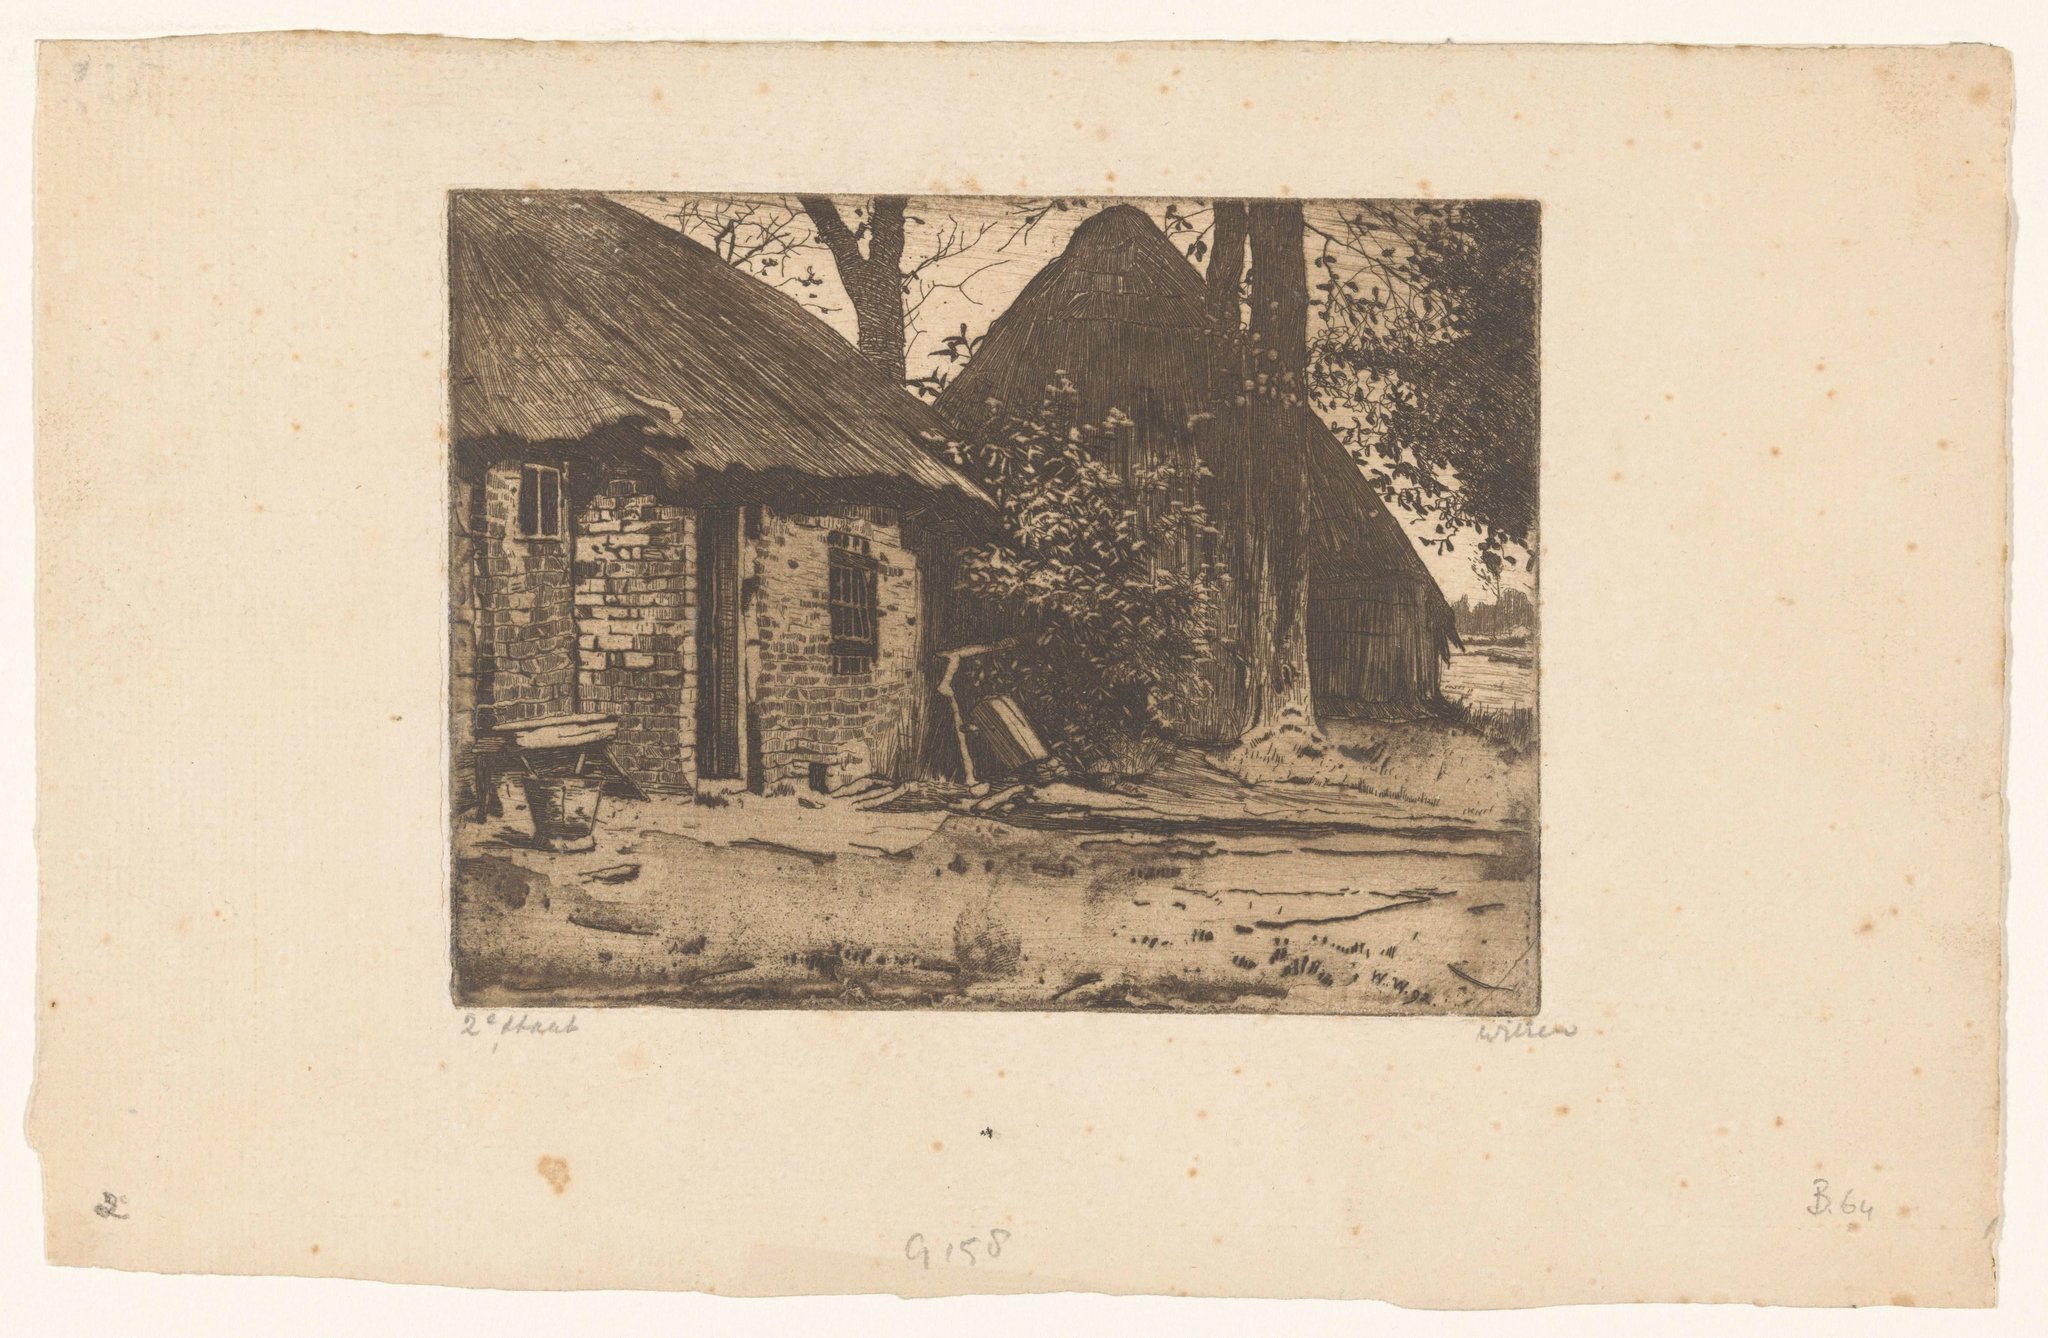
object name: print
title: Boerderij met schuur in Brabant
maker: willem witsen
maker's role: draughtsman, painter, print maker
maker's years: 1860-1923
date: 1892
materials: paper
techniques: aquatint, etching, intaglio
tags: barn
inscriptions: watermark, inscription: ‘2e staat 2e’, signature: ‘Witsen’